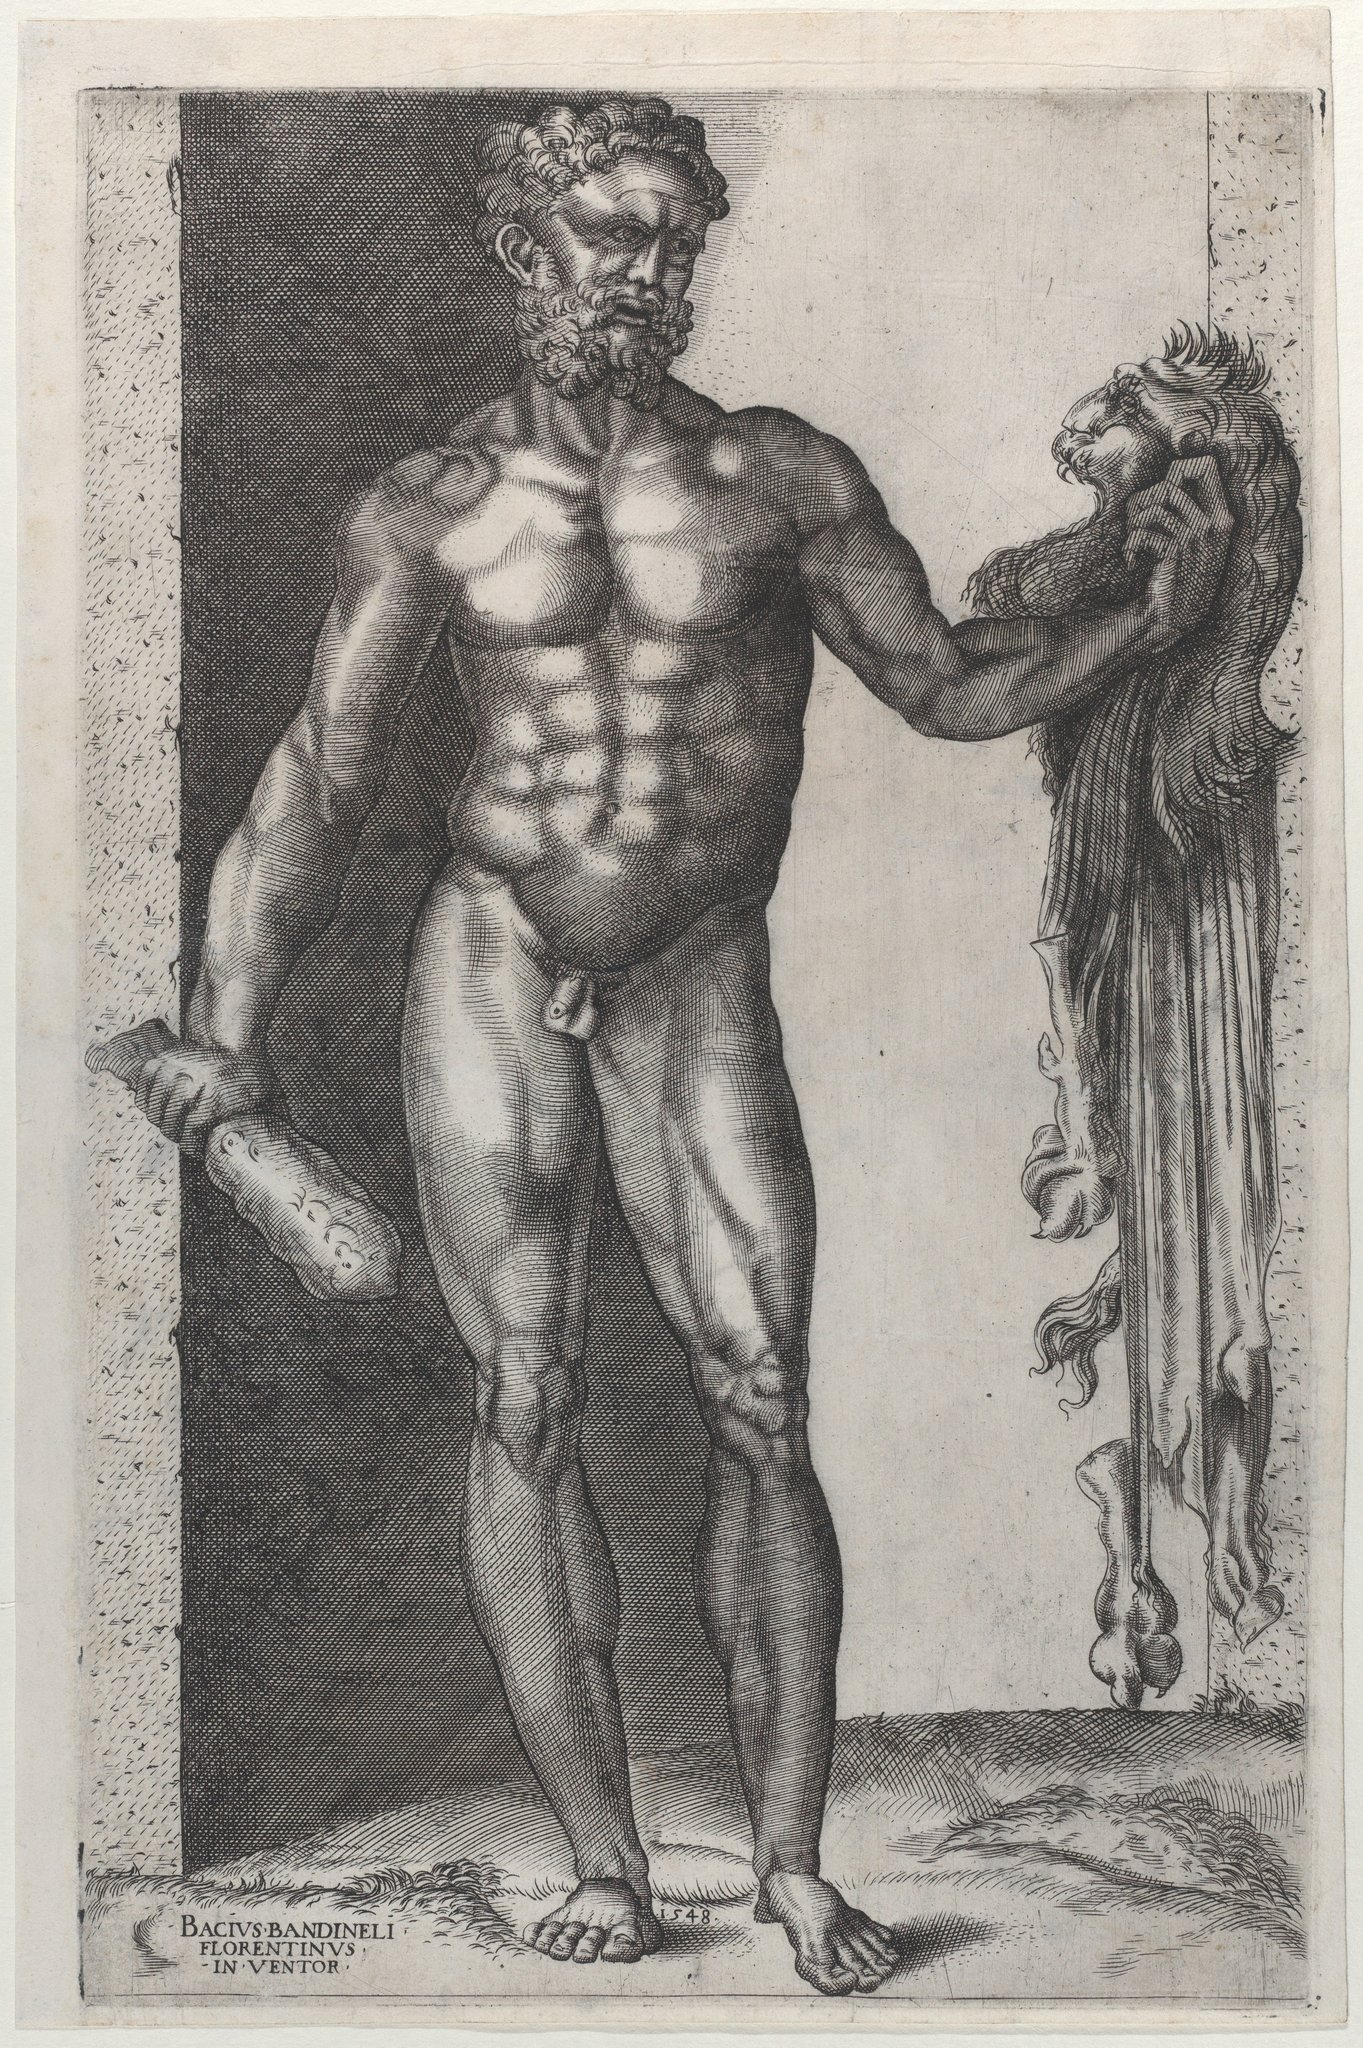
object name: print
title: Hercules with his Club and Lion Skin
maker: anonymous, 16th century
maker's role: artist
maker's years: 1500-1600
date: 1548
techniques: engraving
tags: male nudes,hercules